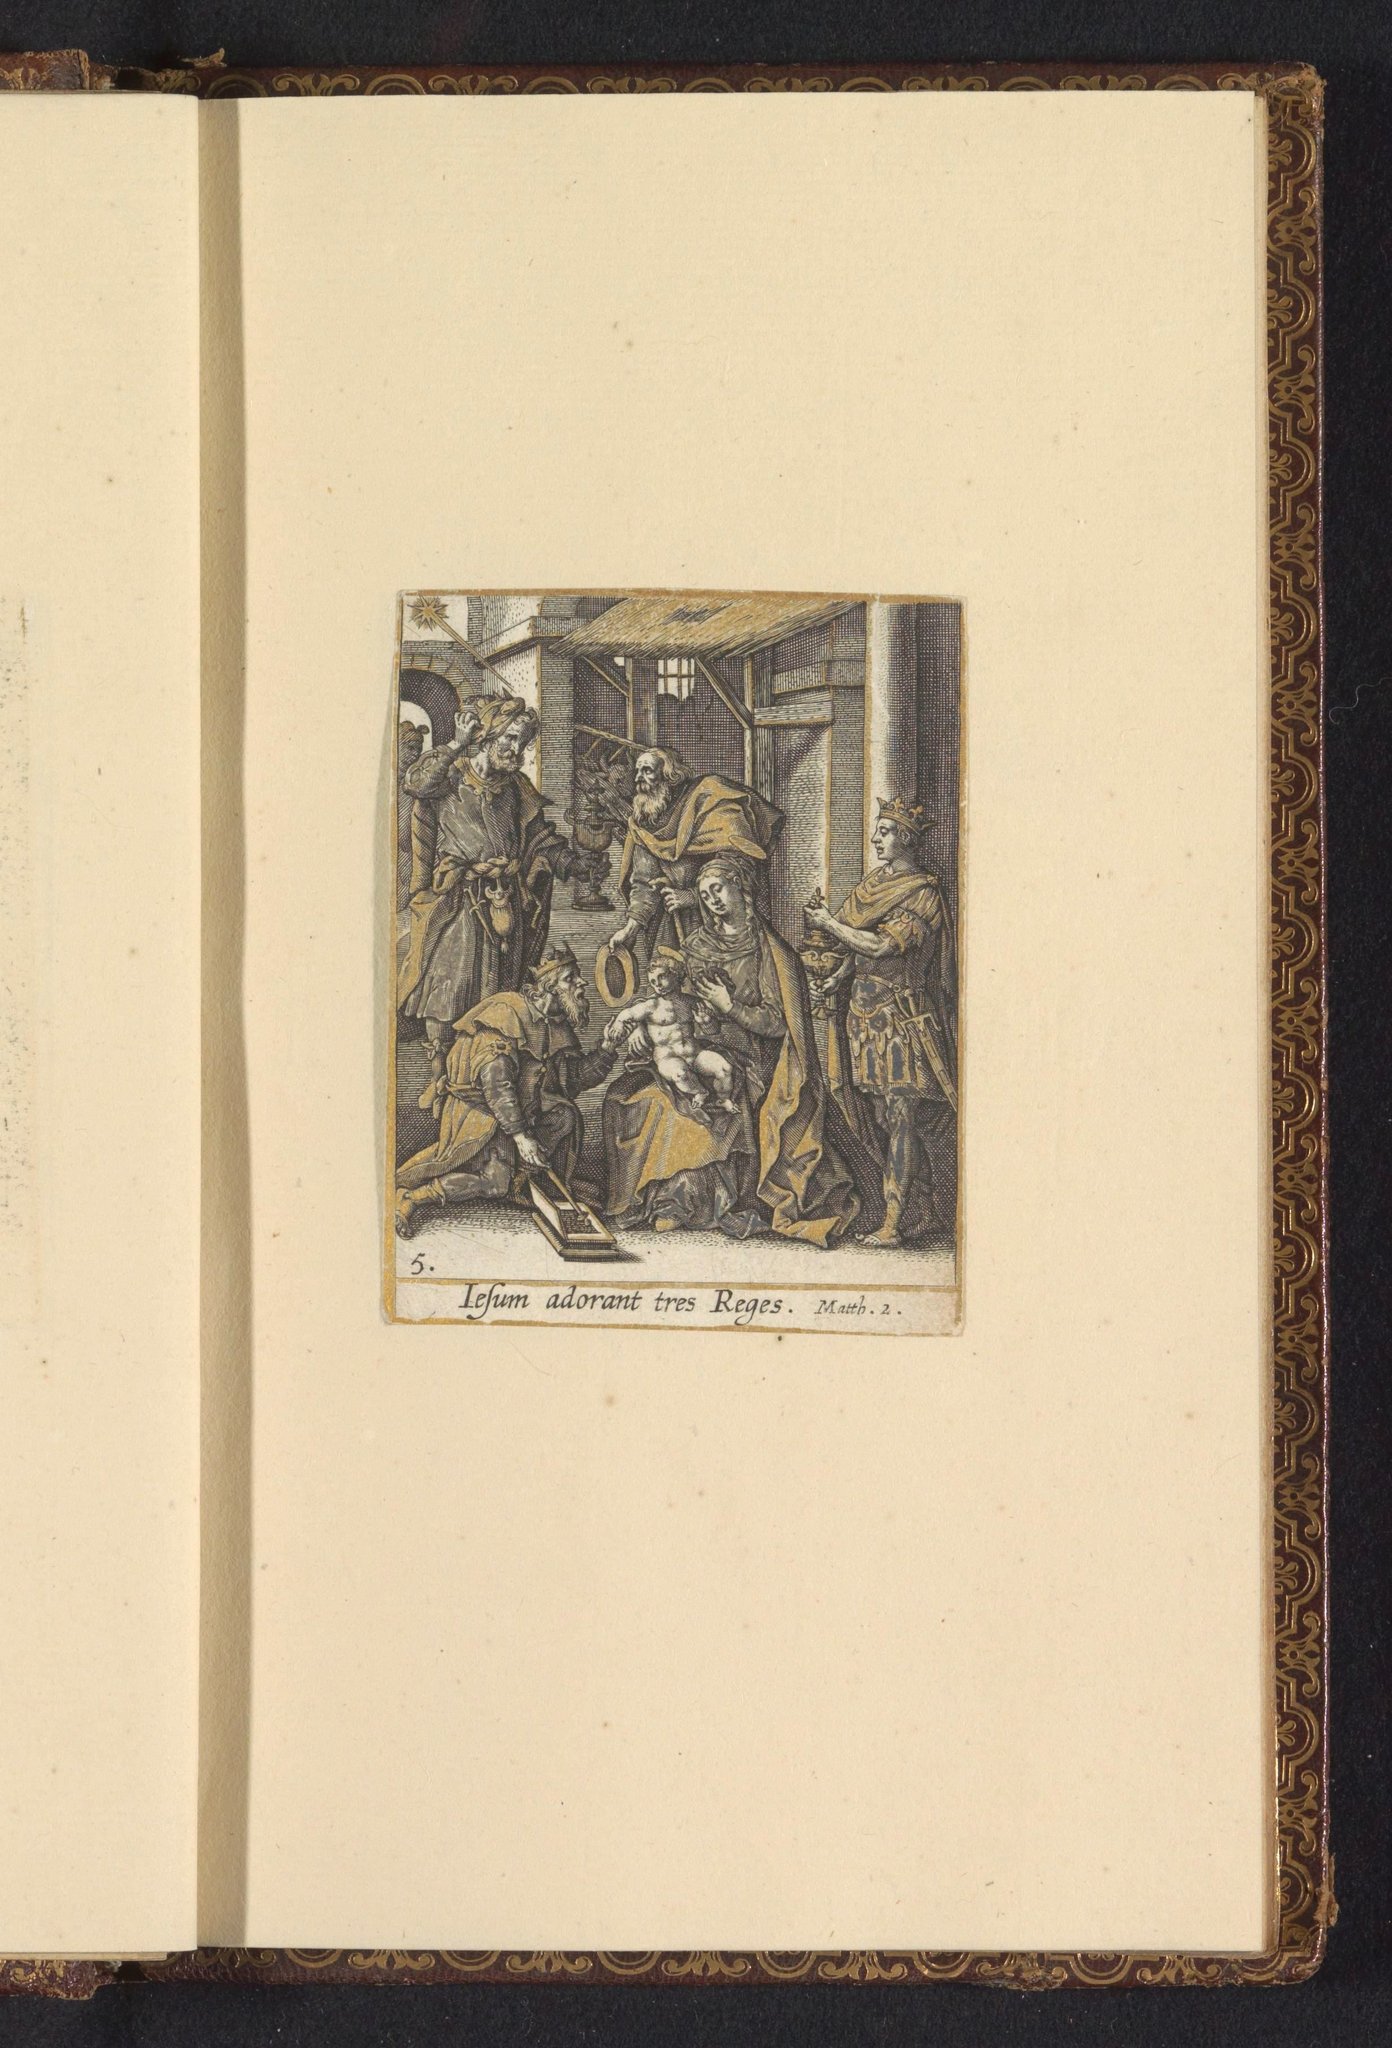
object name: print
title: Aanbidding der koningen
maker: adriaen collaert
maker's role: draughtsman, print maker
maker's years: 1560-1618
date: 1580-1590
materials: gold, paper, silver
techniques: engraving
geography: antwerp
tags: adoration of the kings: the wise men present their gifts to the christ-child (gold, frankincense and myrrh)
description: De gravures van beide reeksen zijn door dezelfde hand gehoogd met goud en zilver. De eerste reeks van 34 (van 35) gravures is een verkleinde versie naar prenten uit een reeks naar Maarten de Vos (nrs. 2-28, 31-33) met toevoeging van drie scènes uit de Wonderen van Christus (nrs. 26, 28, 30).